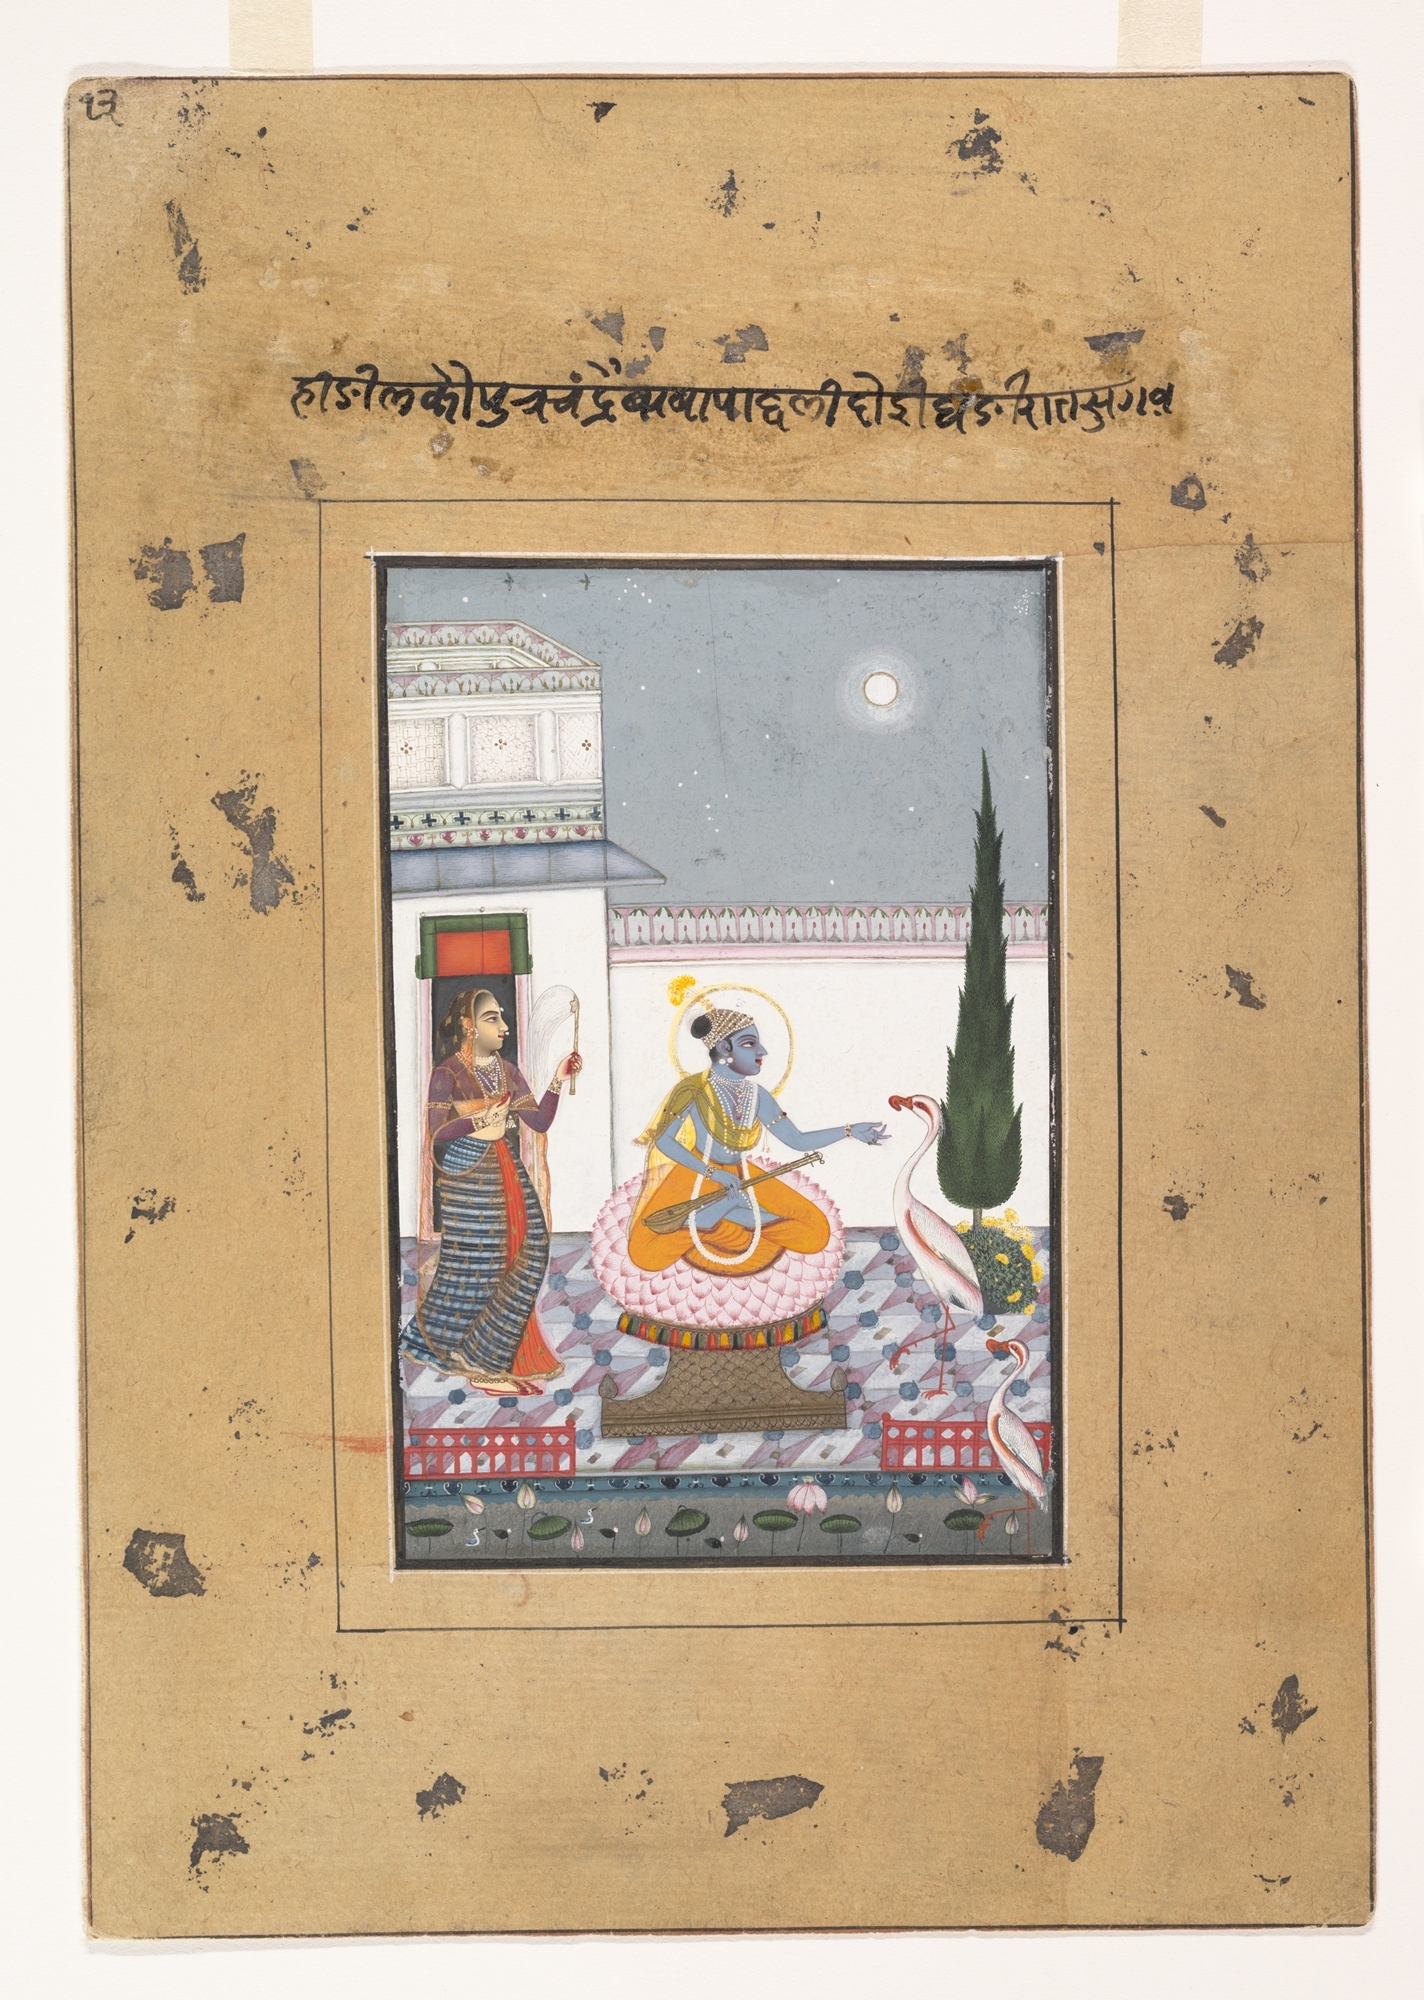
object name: folio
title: Chandravimba Ragaputra: Page from a Dispersed "Boston" Ragamala Series (Garland of Musical Modes)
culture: indian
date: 1760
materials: ink, paper, silver, watercolor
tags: cranes,women,lutes,krishna